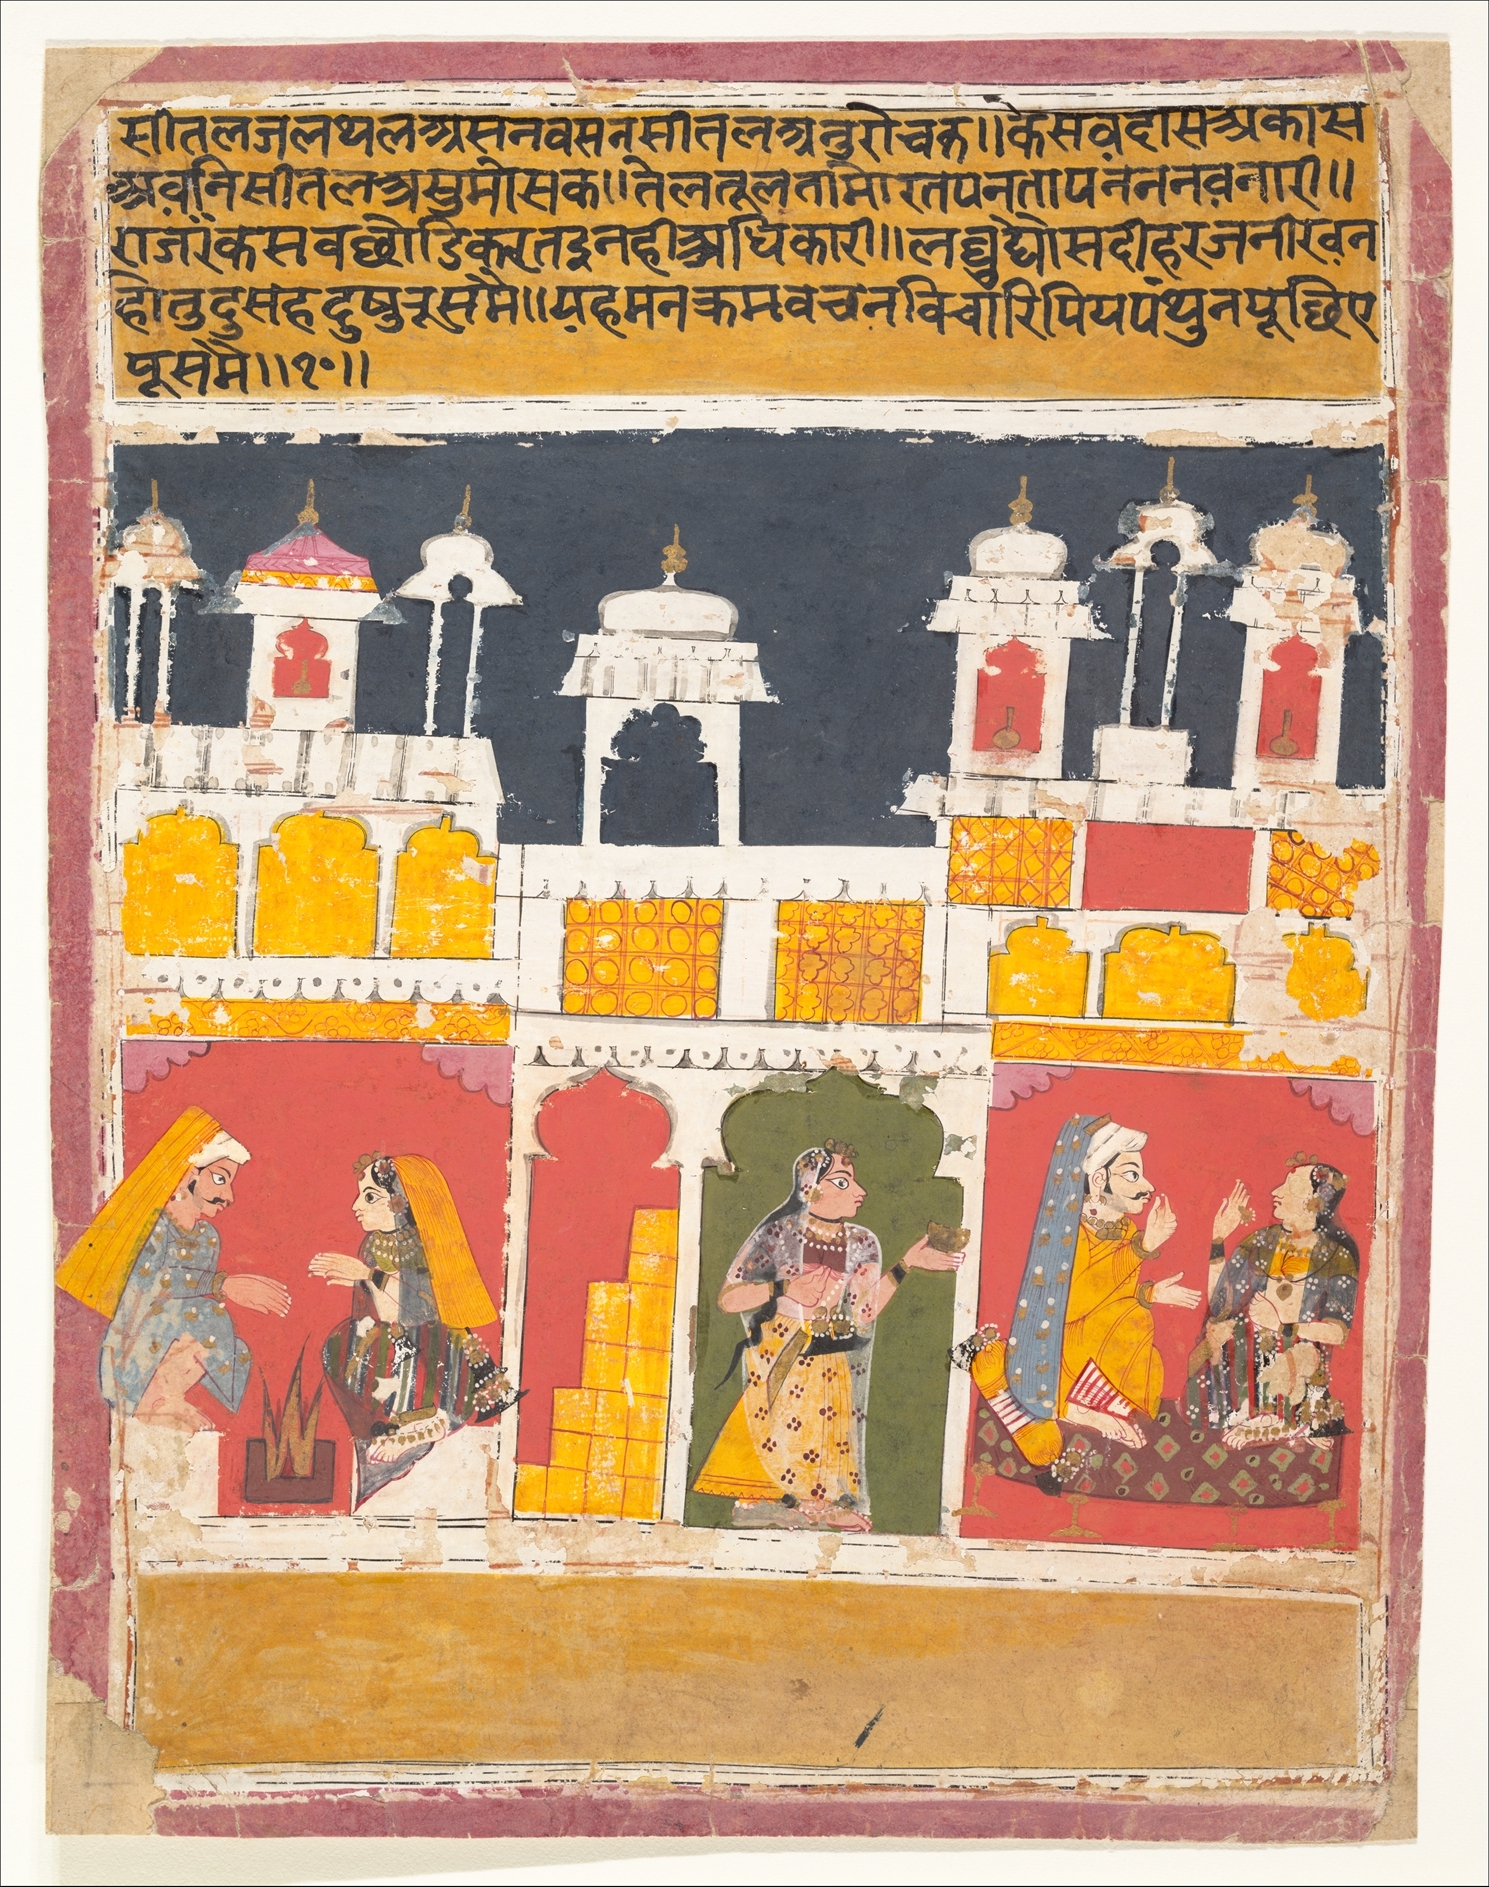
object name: folio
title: Page from a Dispersed Rasikapriya (Lover's Breviary)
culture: indian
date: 1650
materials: ink, paper, watercolor